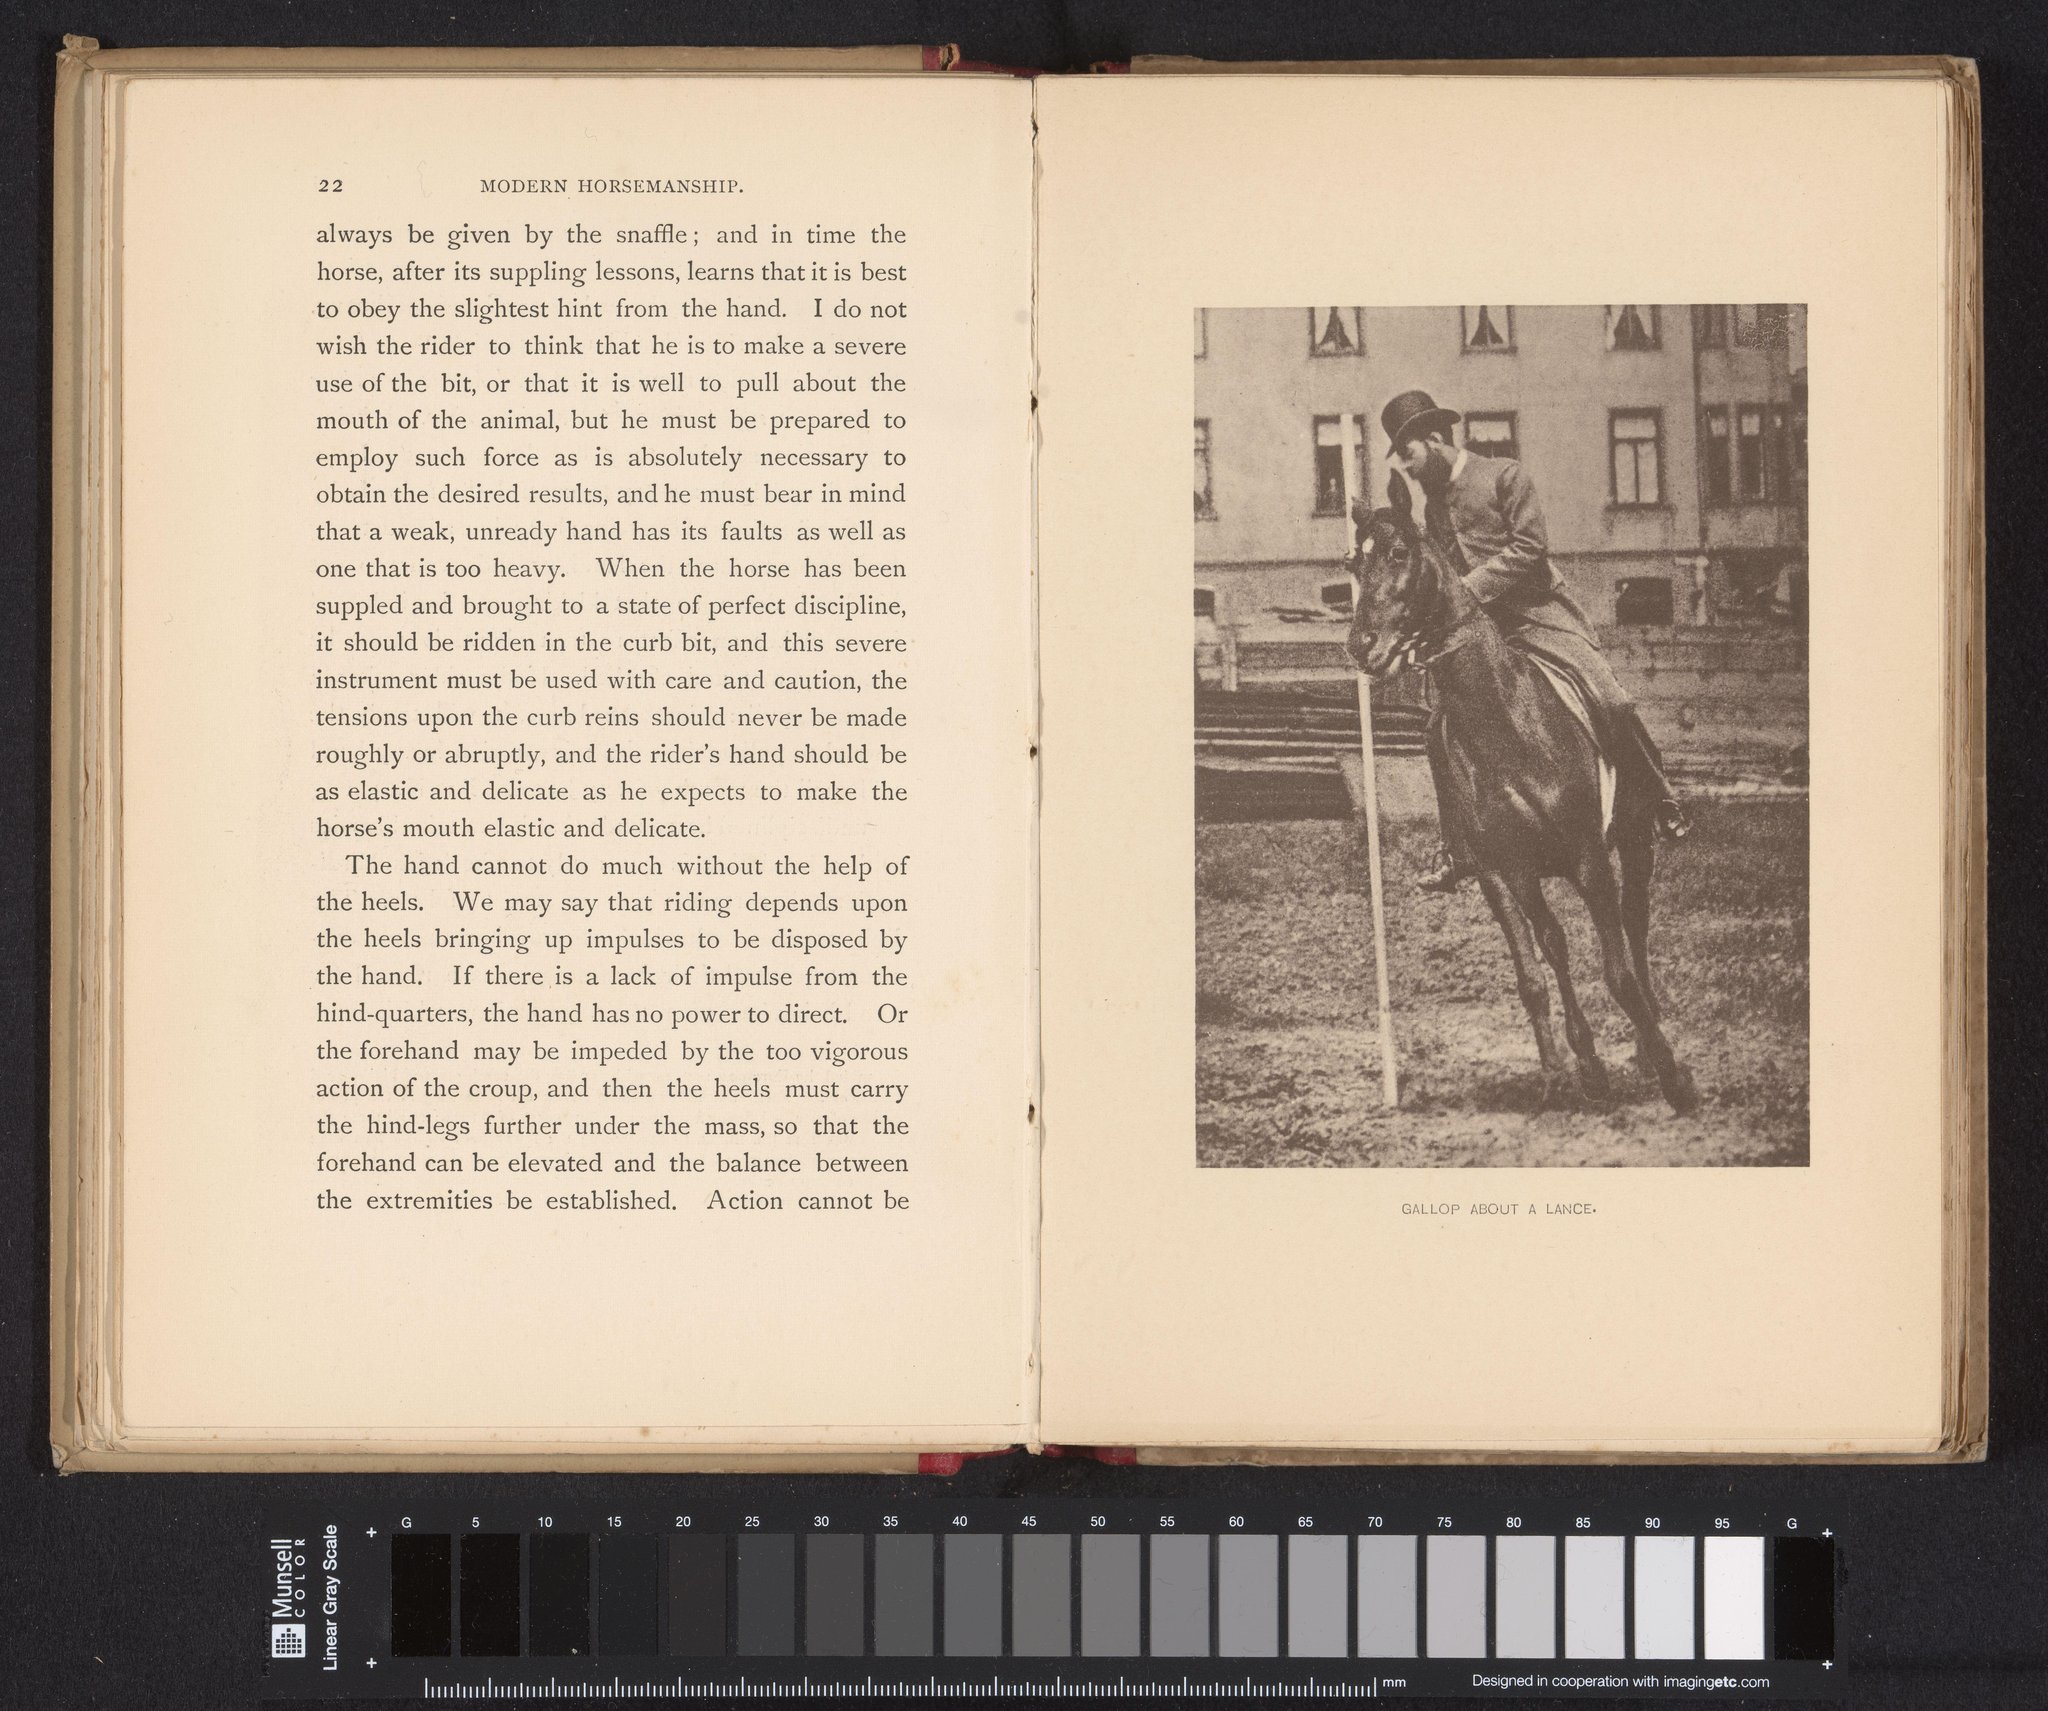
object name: photomechanical print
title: Man die op een paard in galop rijdt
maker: Anonymous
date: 1879-1889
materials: paper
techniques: photograph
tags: riding a horse, ass, or mule; rider, horseman, head-gear: bowler hat, galloping horse